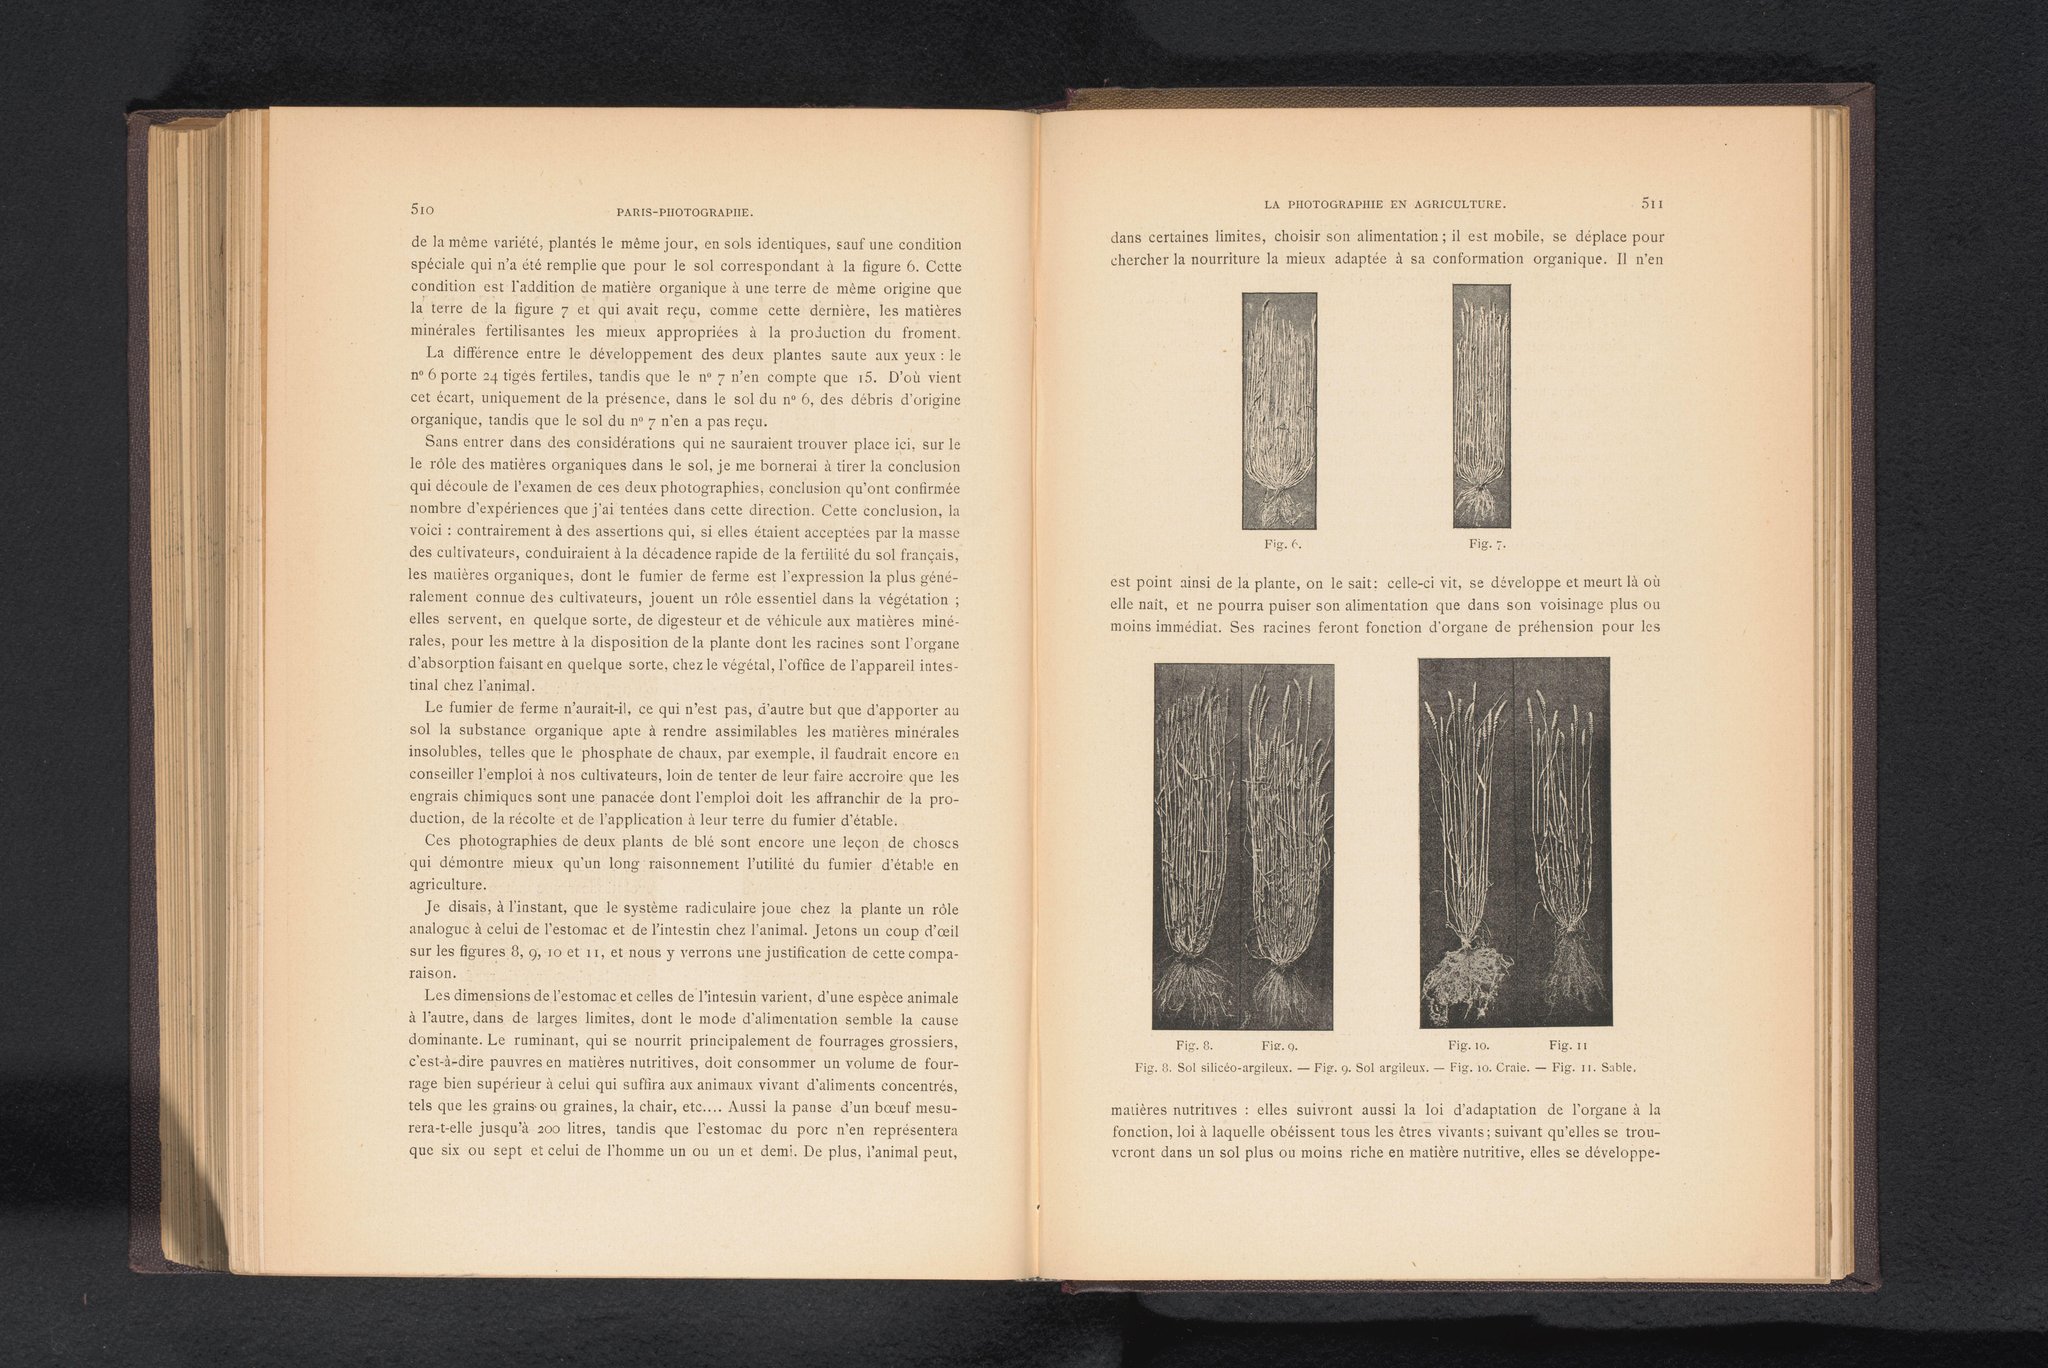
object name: photomechanical print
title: Tarwe met verschillende grond aan de wortels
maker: Anonymous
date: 1882-1892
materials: paper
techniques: autotype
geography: france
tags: plants and herbs: wheat, soil types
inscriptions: inscription: ‘Sol silicéo-argileux. Sol argileux. Craie. Sable.’, number: ‘Fig. 6. Fig. 7. Fig. 8. Fig. 9. Fig. 10. Fig. 11.’